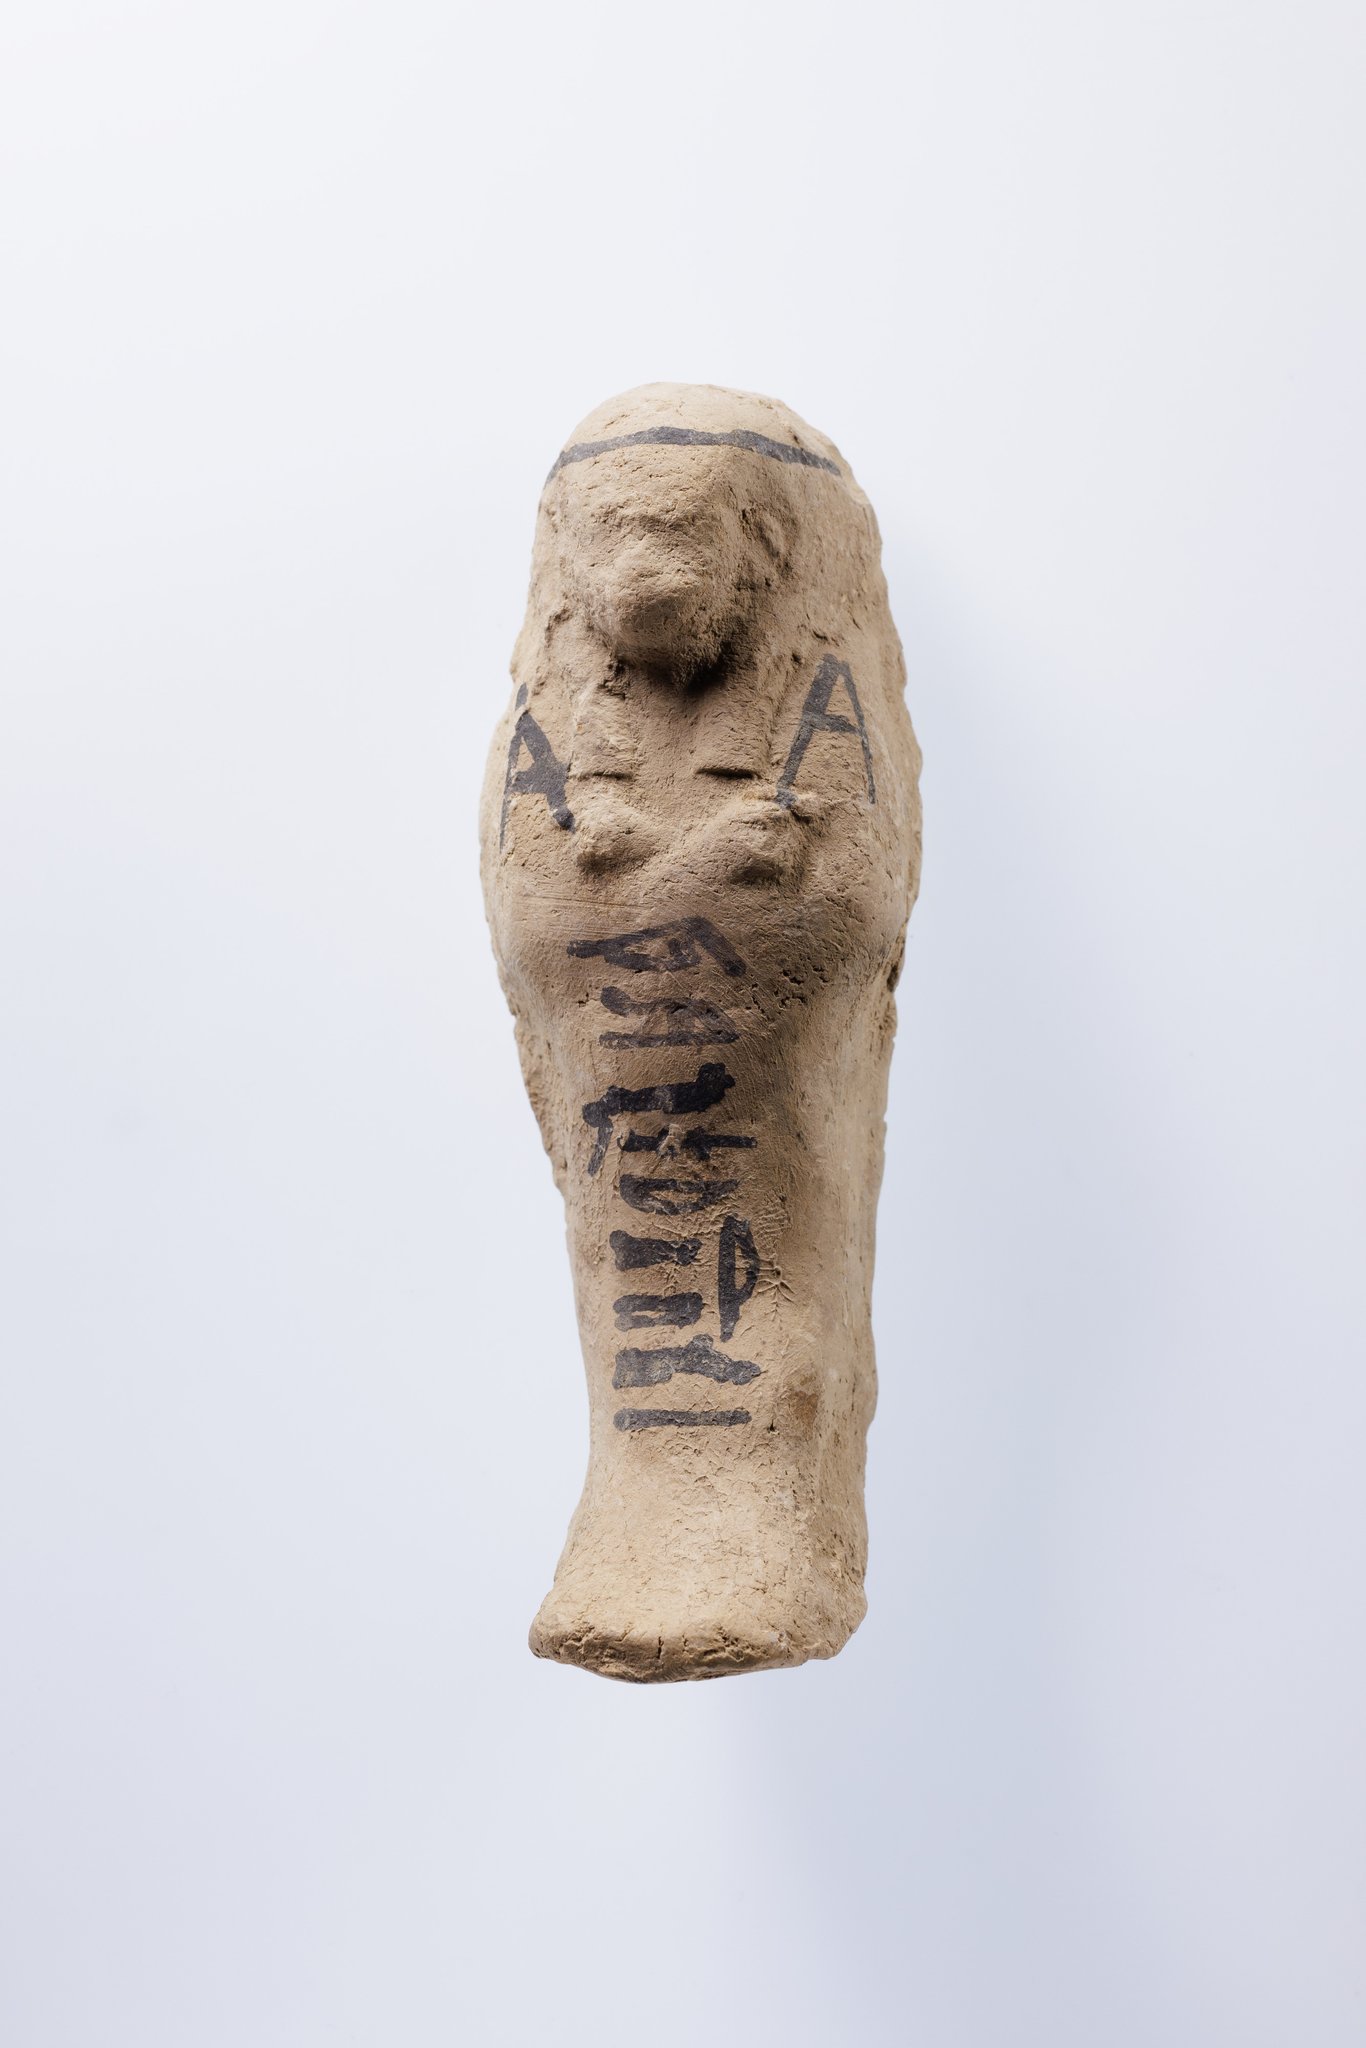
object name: shabti, nesinebtasheru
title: Shabti of Nesinebtasheru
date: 1070-945 BCE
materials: clay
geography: egypt